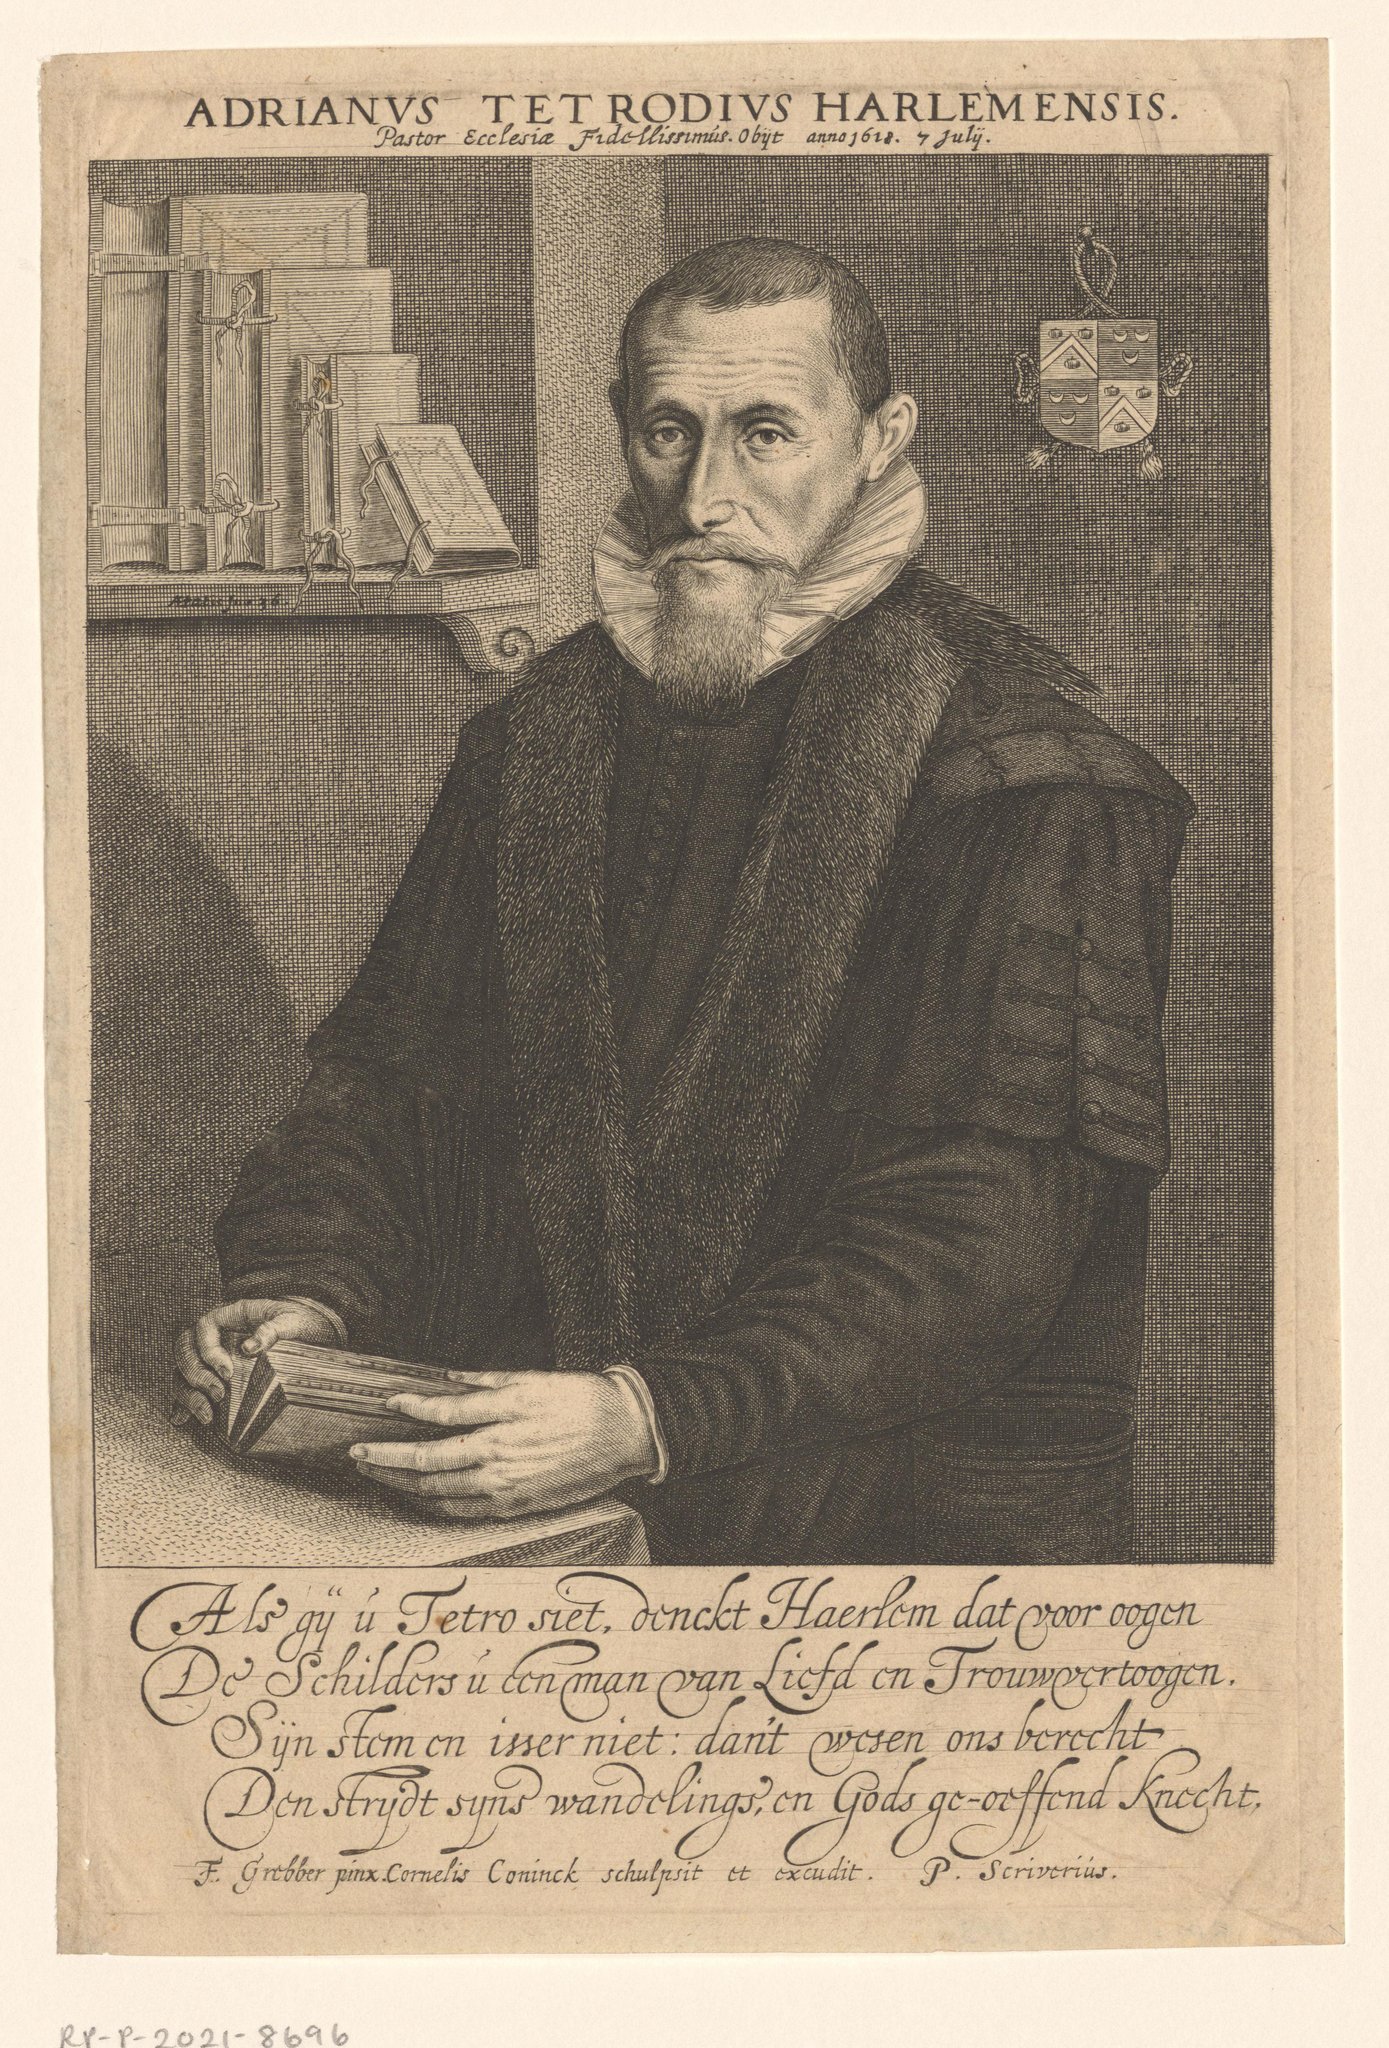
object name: print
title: Portret van Adriaan van Tetrode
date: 1618-1671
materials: paper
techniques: engraving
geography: haarlem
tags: bookshelves, historical persons, functionaries and dignitaries ~ episcopal protestant churches, book, armorial bearing, heraldry